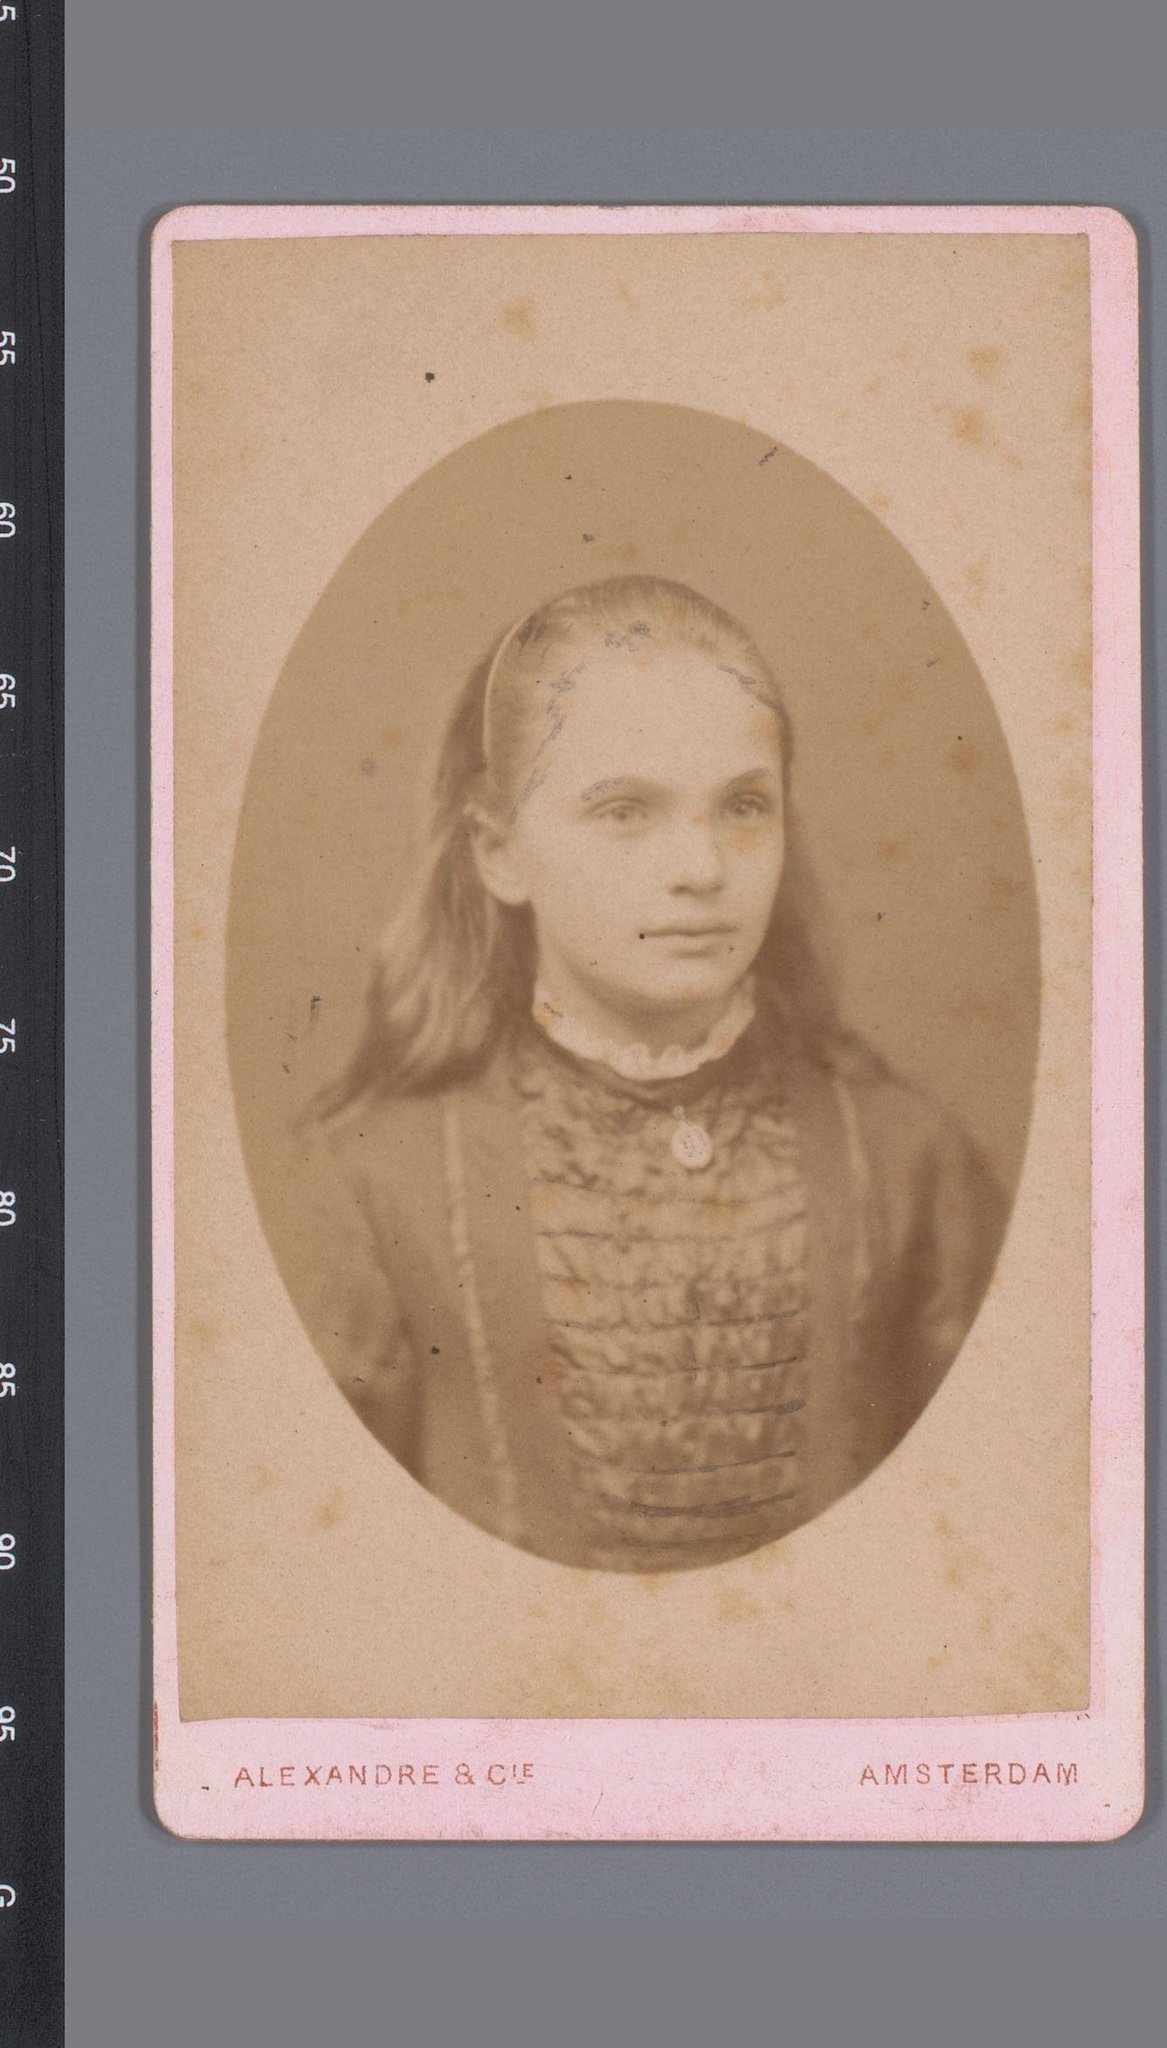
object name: carte de visite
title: Portret van Jacqueline E. van der Waals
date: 1876-1900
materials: cardboard, photographic support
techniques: albumen print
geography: amsterdam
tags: the hague, amsterdam, historical persons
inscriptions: workshop stamp: ‘Photographie Belge/ Alexandre & Cie/ 162, Kalverstraat, Amsterdam’